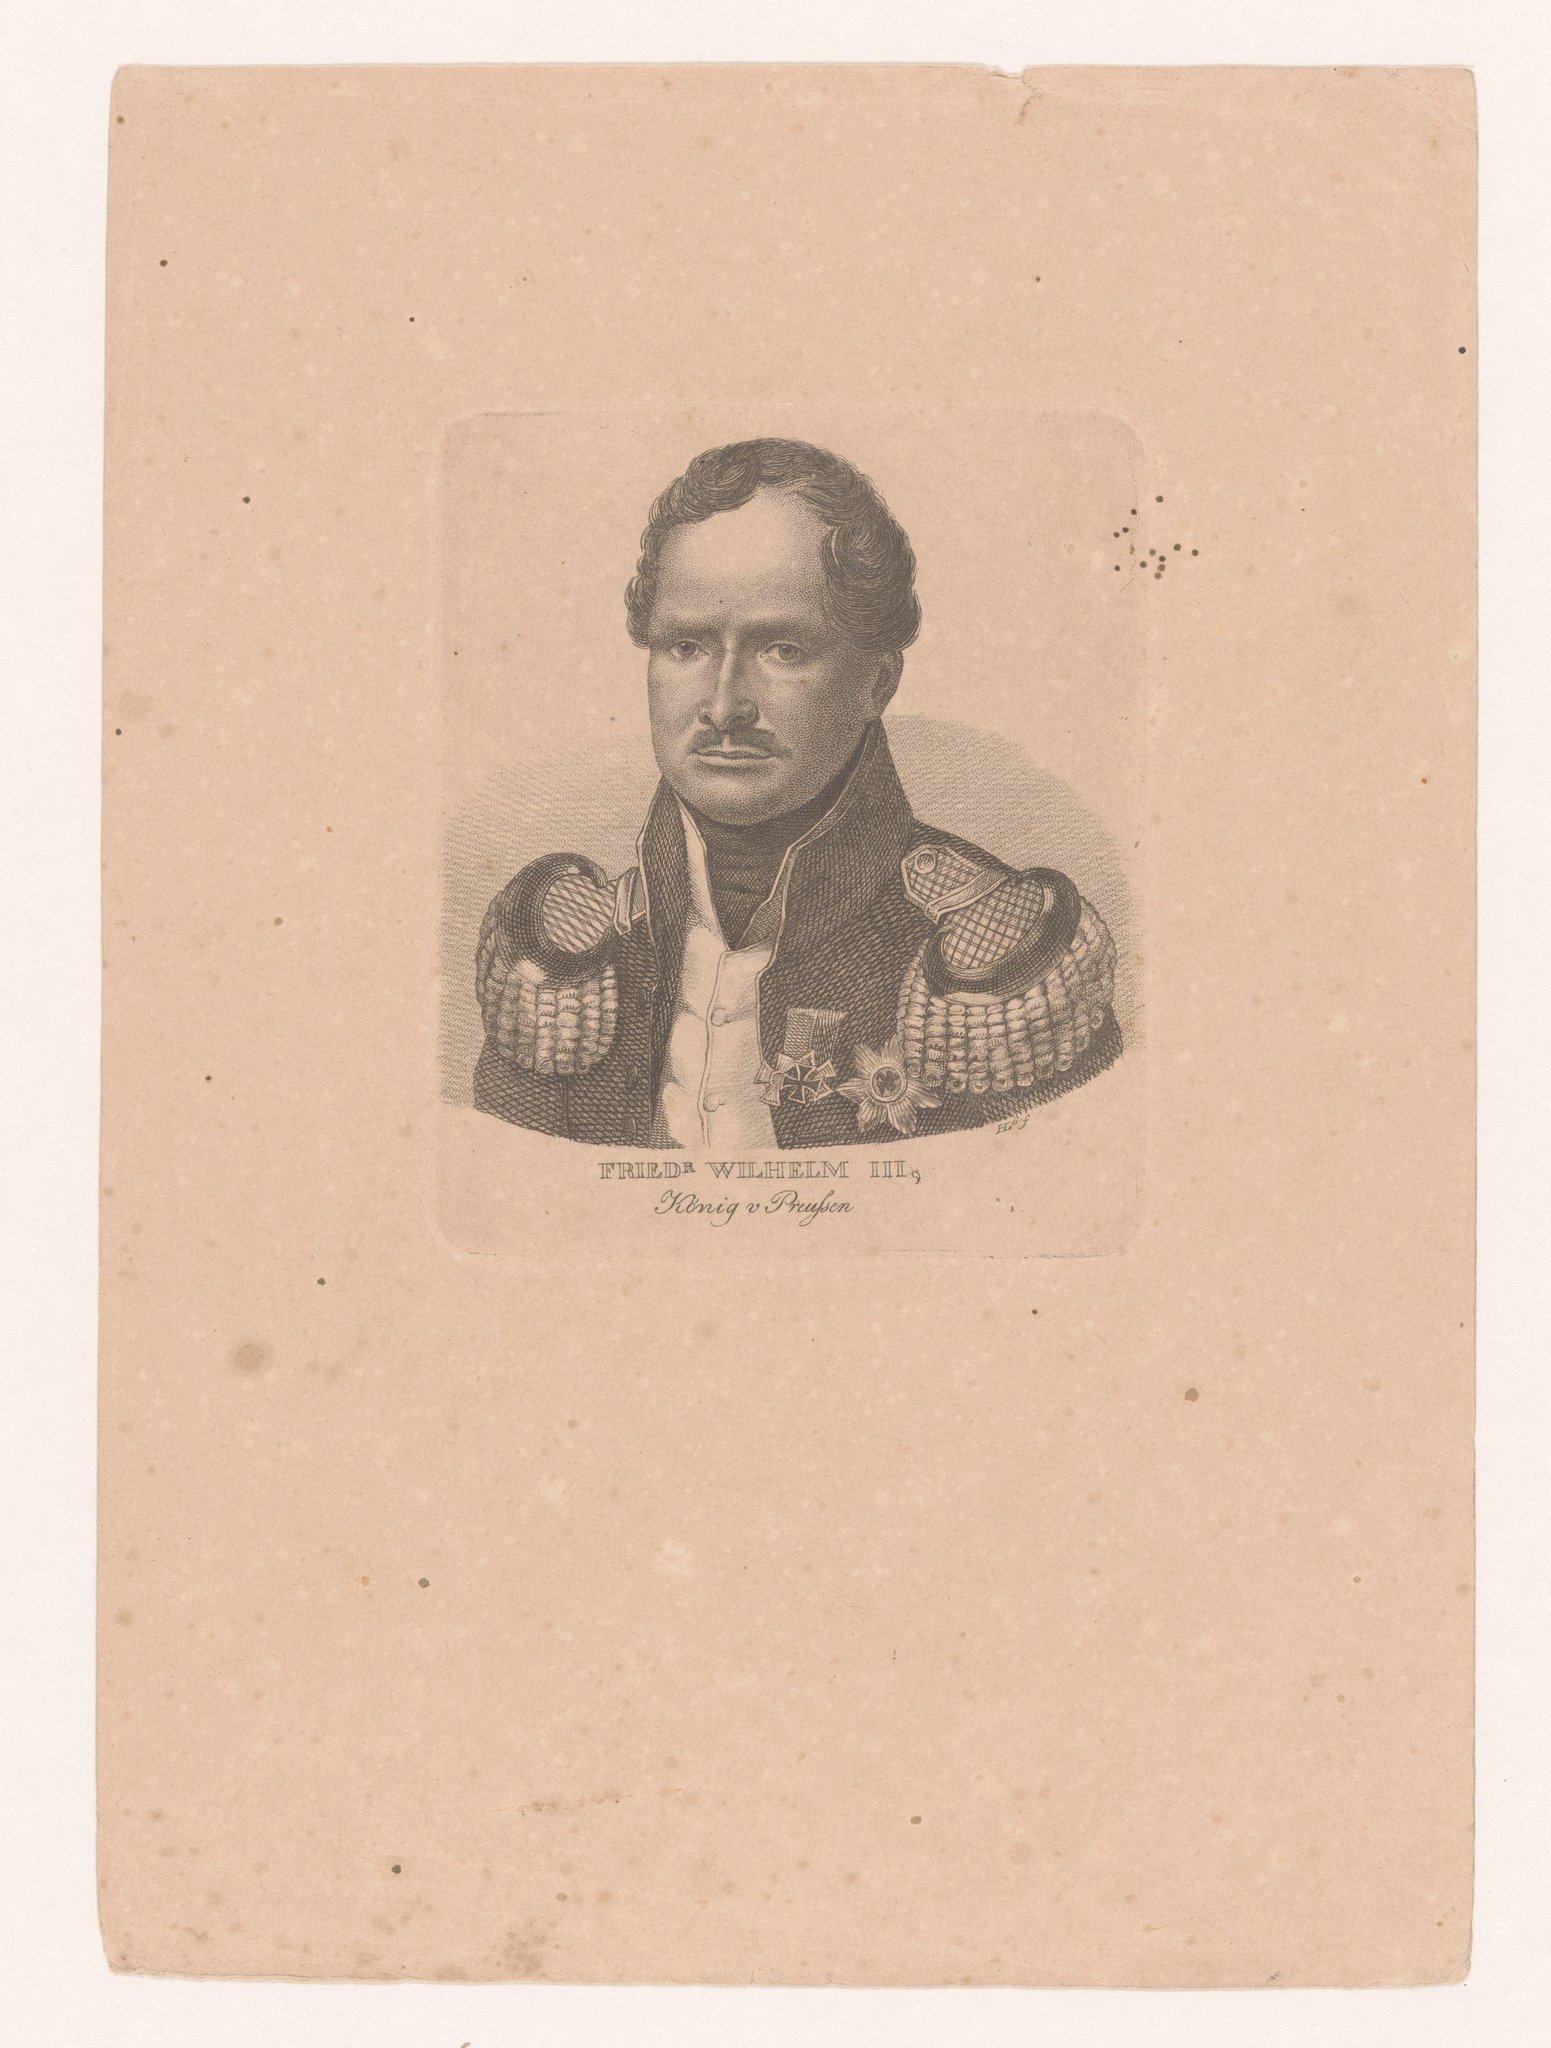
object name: print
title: Portret van Friedrich Wilhelm III van Pruisen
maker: monogrammist hlo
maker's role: print maker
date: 1797-1849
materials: paper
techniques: etching, engraving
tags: berlin, frederik willem iii koning van pruisen, historical persons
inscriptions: collector's mark: Lugt 2228